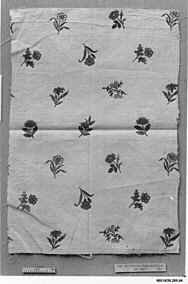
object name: floral print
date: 1785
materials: cotton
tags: flowers